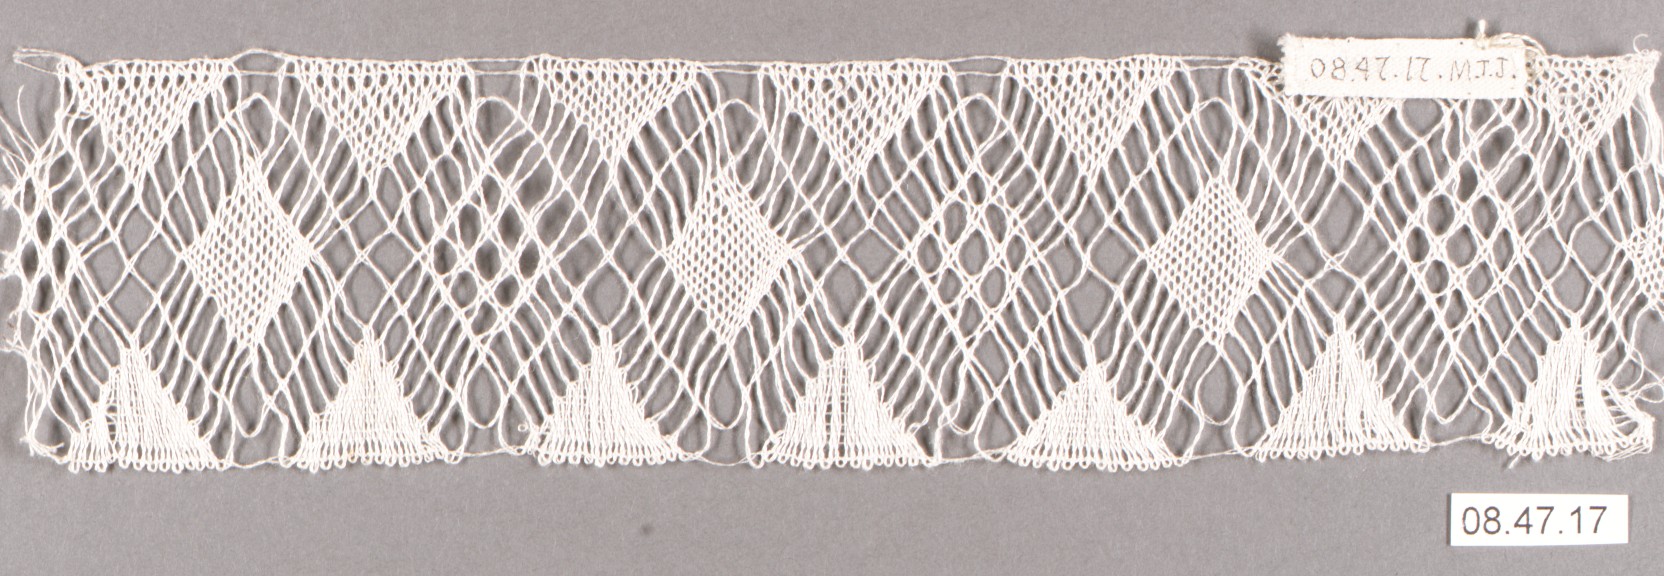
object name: fragment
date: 1801-1900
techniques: lace